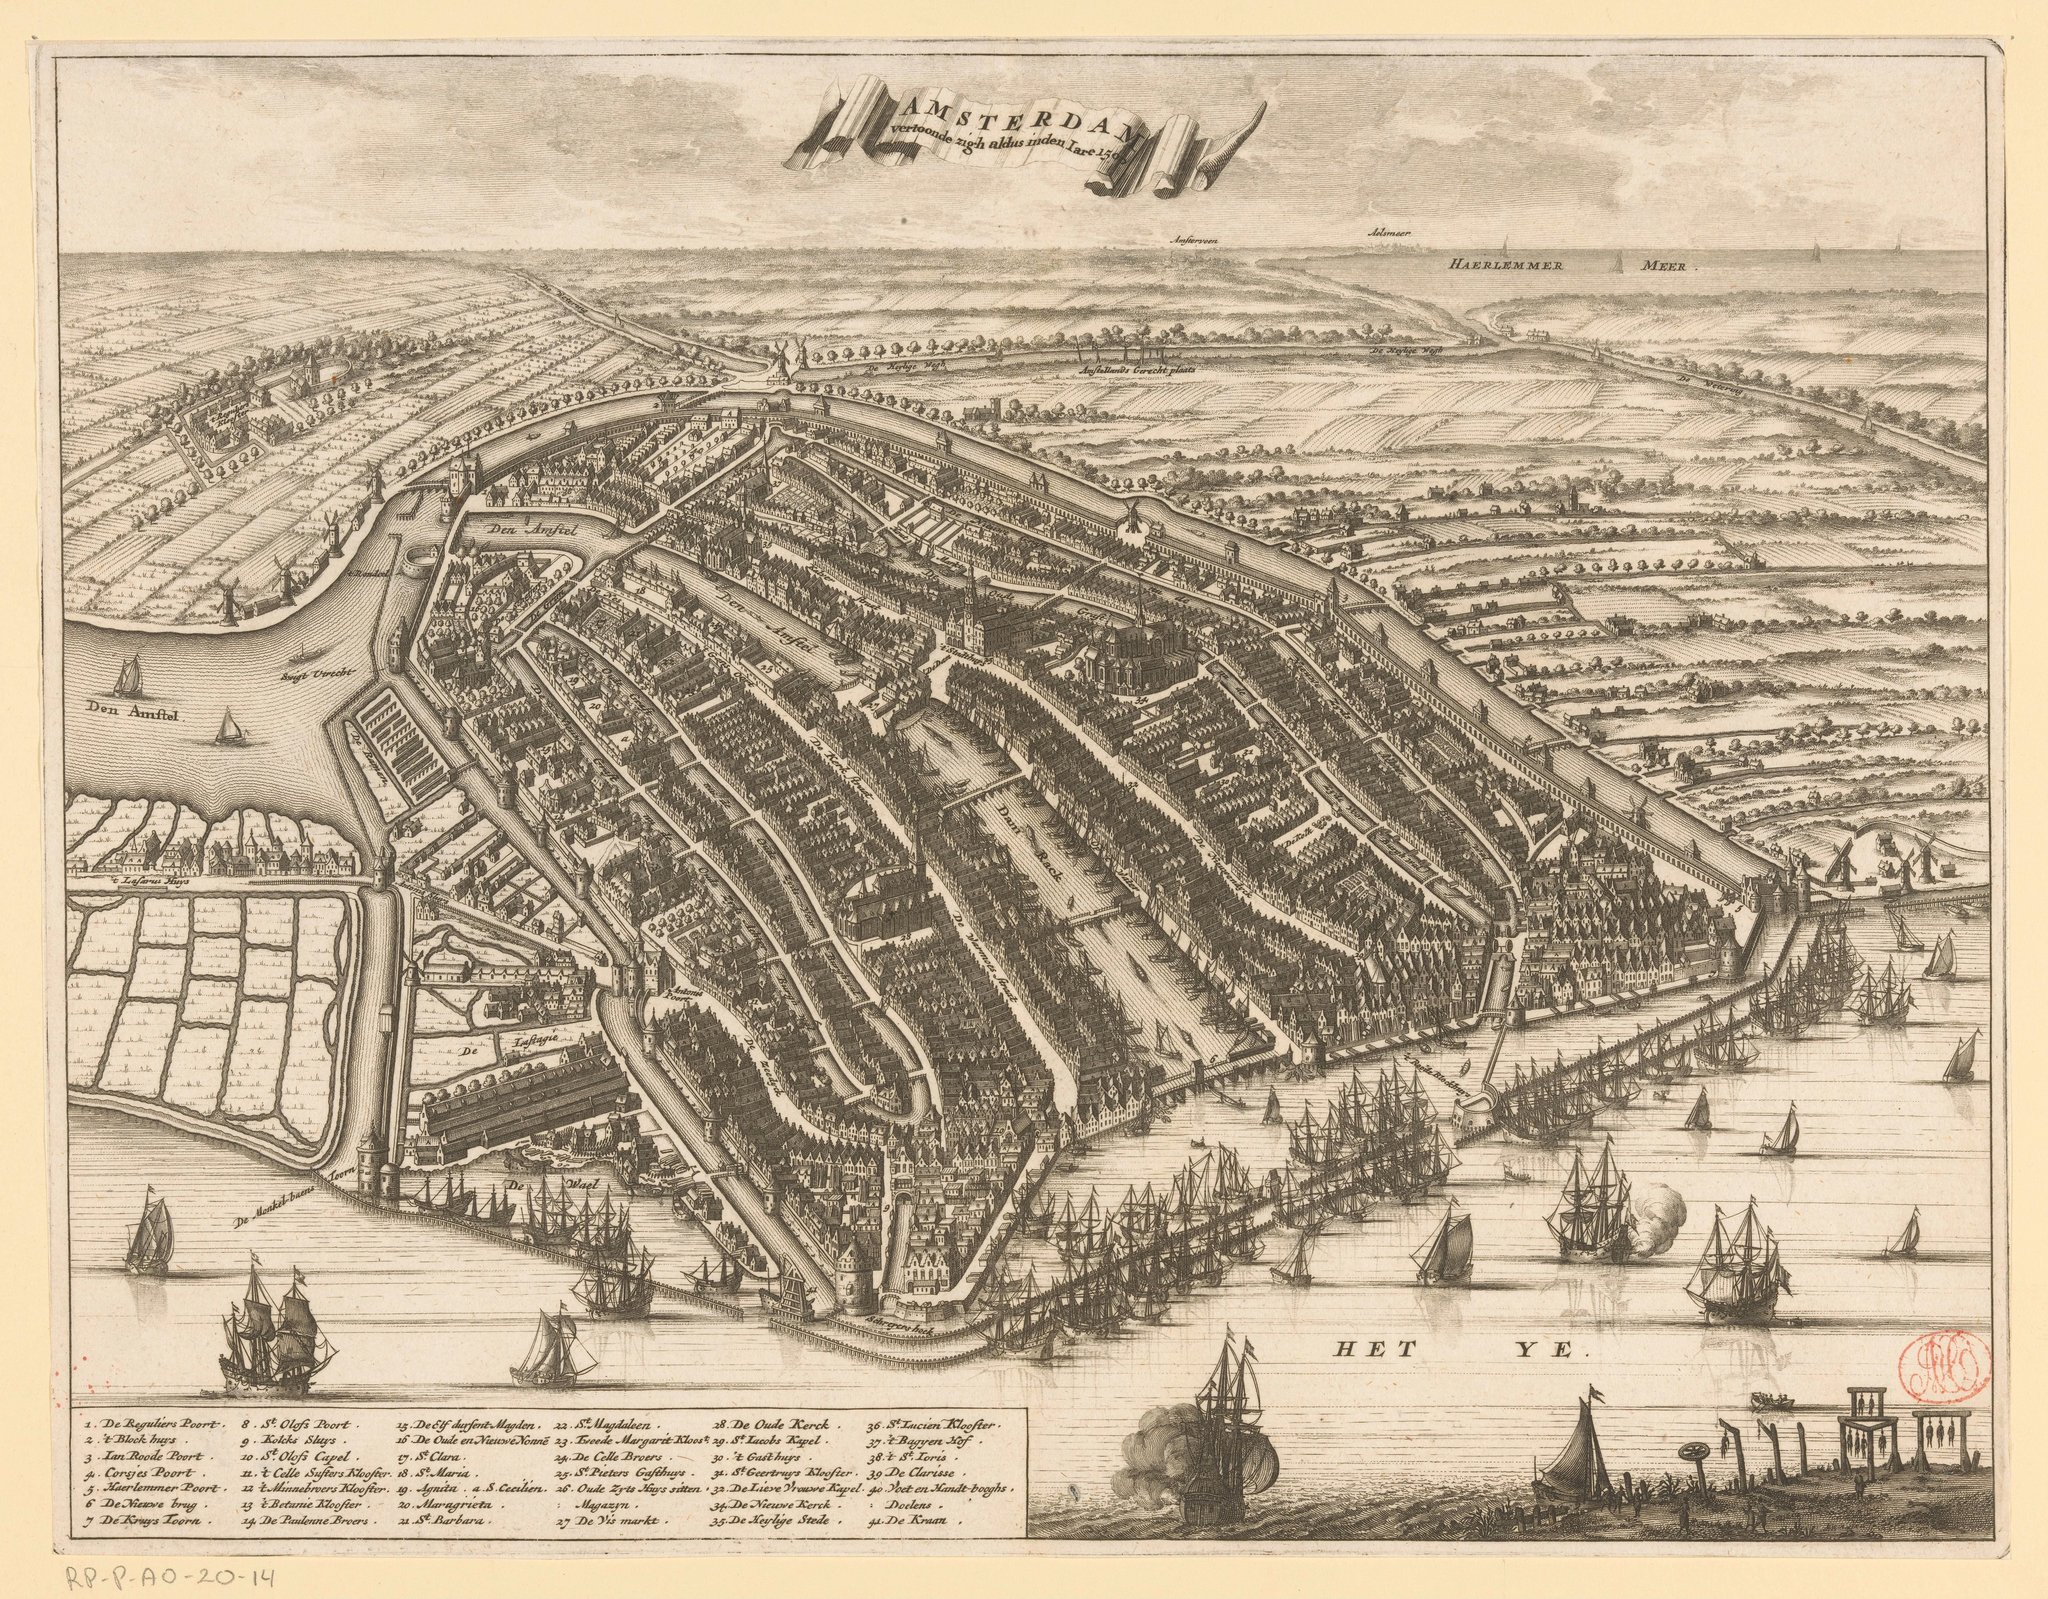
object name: book illustration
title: Plattegrond van Amsterdam, 1500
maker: Anonymous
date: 1693-1726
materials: paper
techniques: engraving, etching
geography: amsterdam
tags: maps of cities, amsterdam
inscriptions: collector's mark: Lugt 195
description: Prent ook gebruikt in: Commelin, Caspar. Beschryvinge van Amsterdam, desselfs eerste oorspronk uyt den Huyse (…). 2 delen. Amsterdam: Abraham Wolfgang, Gillis Janssonius van Waesberge, Johannes Janssonius van Waesberge II, weduwe Dirk Boom I, Hendrick Boom en Rembertus Goethals, 1693. En in: Commelin, Caspar. Beschryvinge van Amsterdam, zynde een naukeurige verhandelinge van desselfs eerste oorspronk uyt (…). 2 delen. Amsterdam: weduwe Aart Dircksz Oossaan, 1694. En in: Commelin, Caspar. Beschryvinge van Amsterdam, zynde een naukeurige verhandelinge van desselfs eerste oorspronk uyt (…). 2 delen. 2e druk. Amsterdam: Andries van Damme, Johannes Ratelband, weduwe A. van Aaltwyk en Hermanus Uytwerf, 1726.